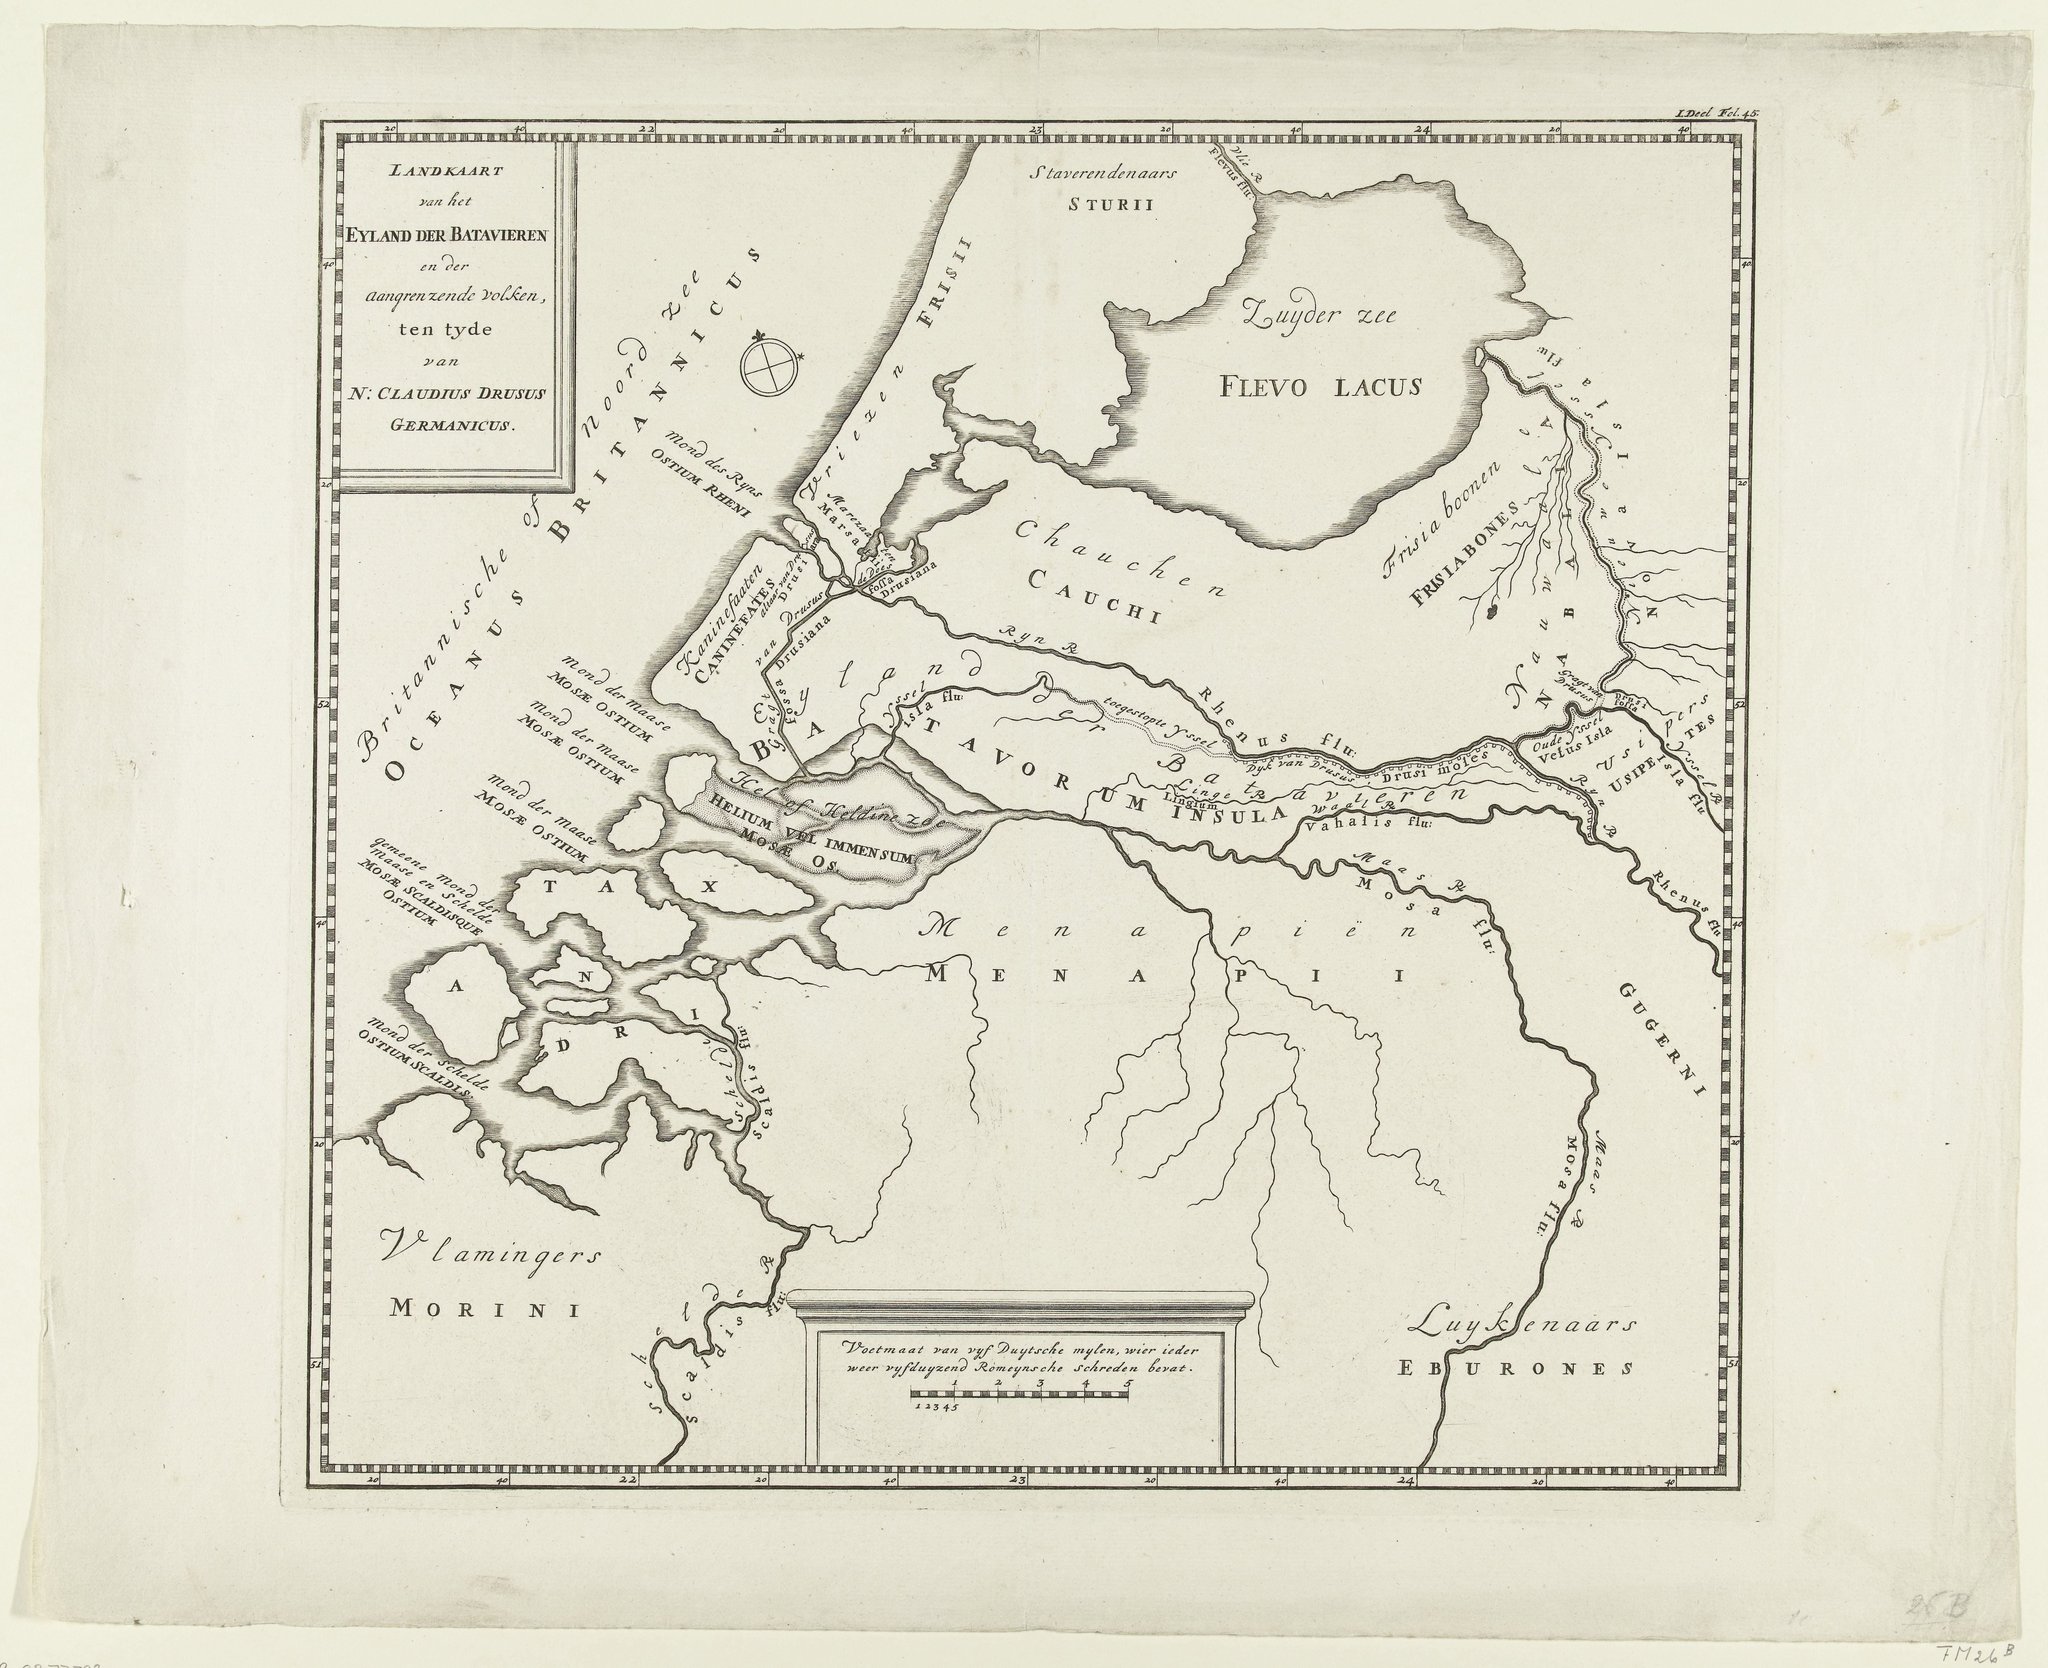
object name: print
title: Landkaart van het Eyland der Batavieren en der aangrenzende volken, ten tyde van N. Claudius Drusus Germanicus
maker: Anonymous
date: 1732-1734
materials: paper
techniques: etching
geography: netherlands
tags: maps of separate countries or regions, netherlands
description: Historische kaart van Nederland met de gebieden van de Bataven. Maakt deel uit van de 8 kaarten in G. van Loon, Aloude Hollandsche Histori... sedert de komst der Batavieren in... Holland, 2 delen, bij Pieter de Hond, 's-Gravenhage 1734. Volgens opschrift geplaatst in: Deel I, fol. 45.